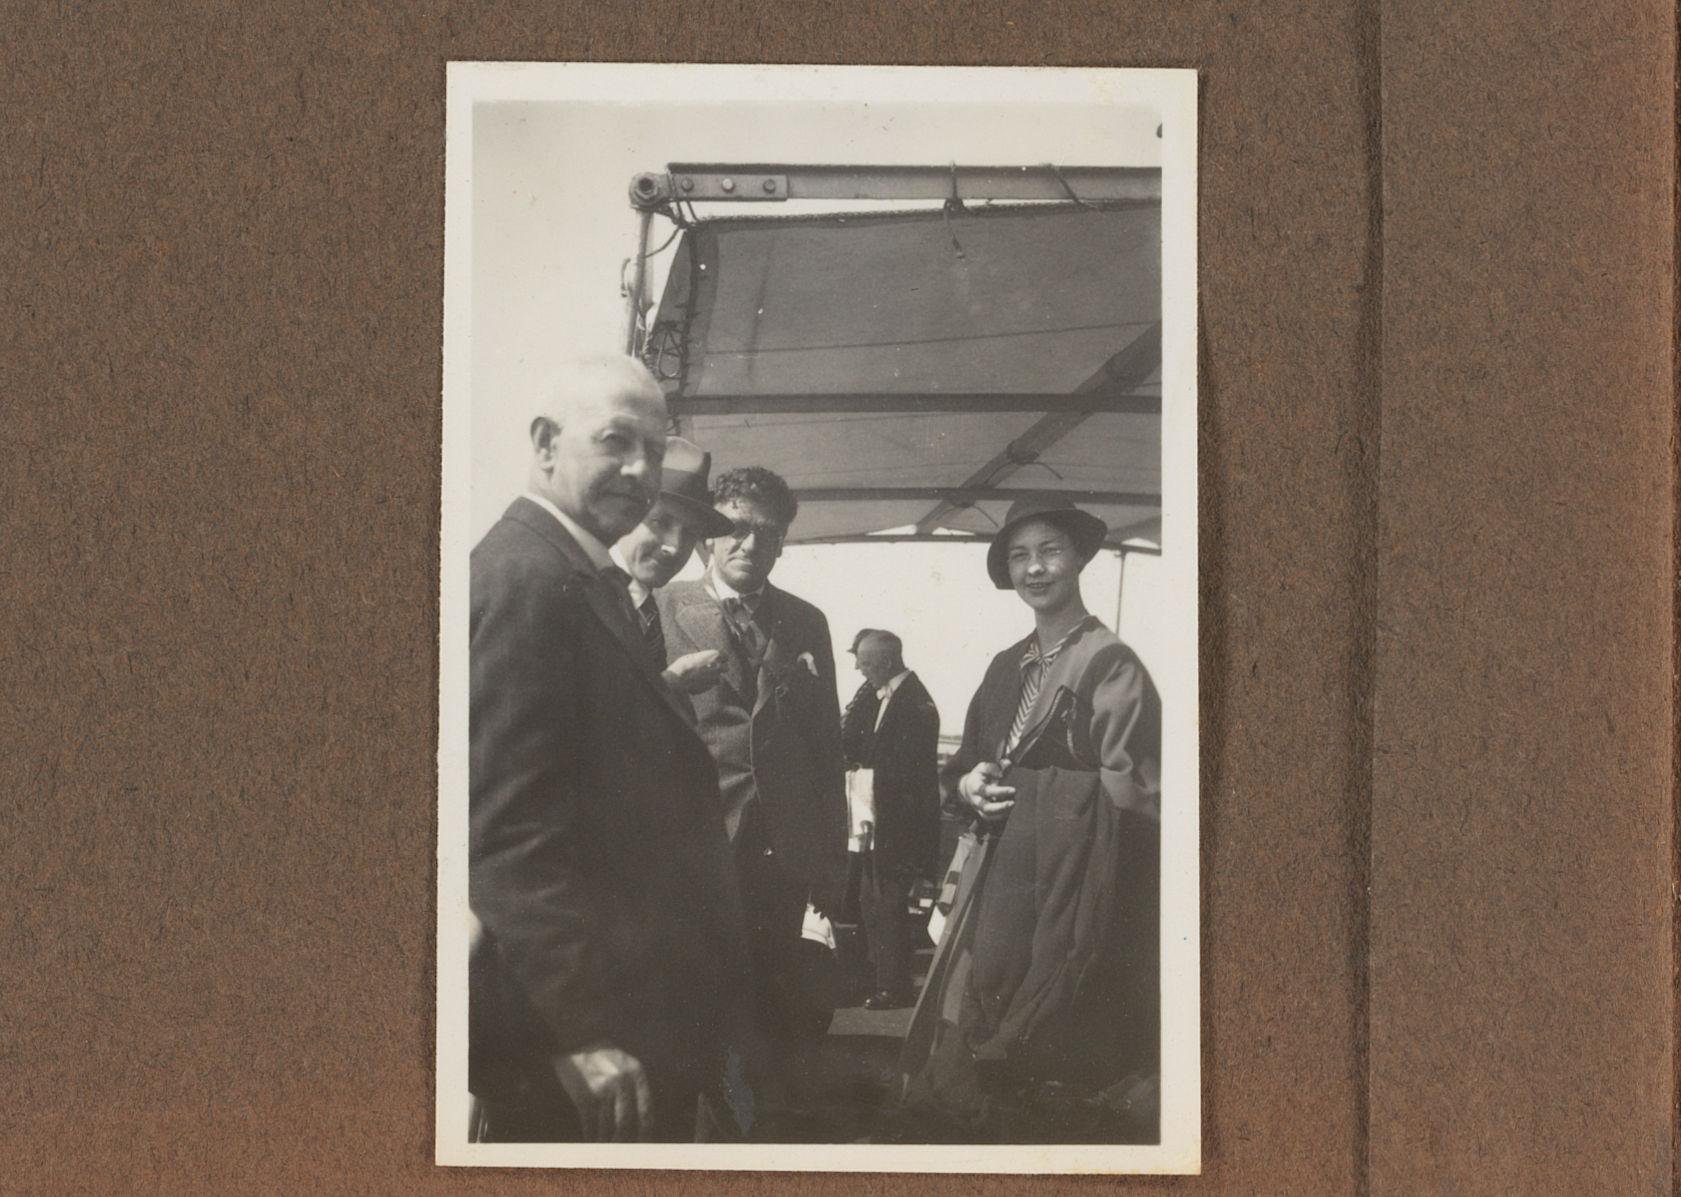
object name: photograph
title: Gezelschap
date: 1900-1920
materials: photographic support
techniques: photography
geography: netherlands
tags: netherlands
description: Foto op bruin albumblad 54 van familiealbum van Alphons Diepenbrock.